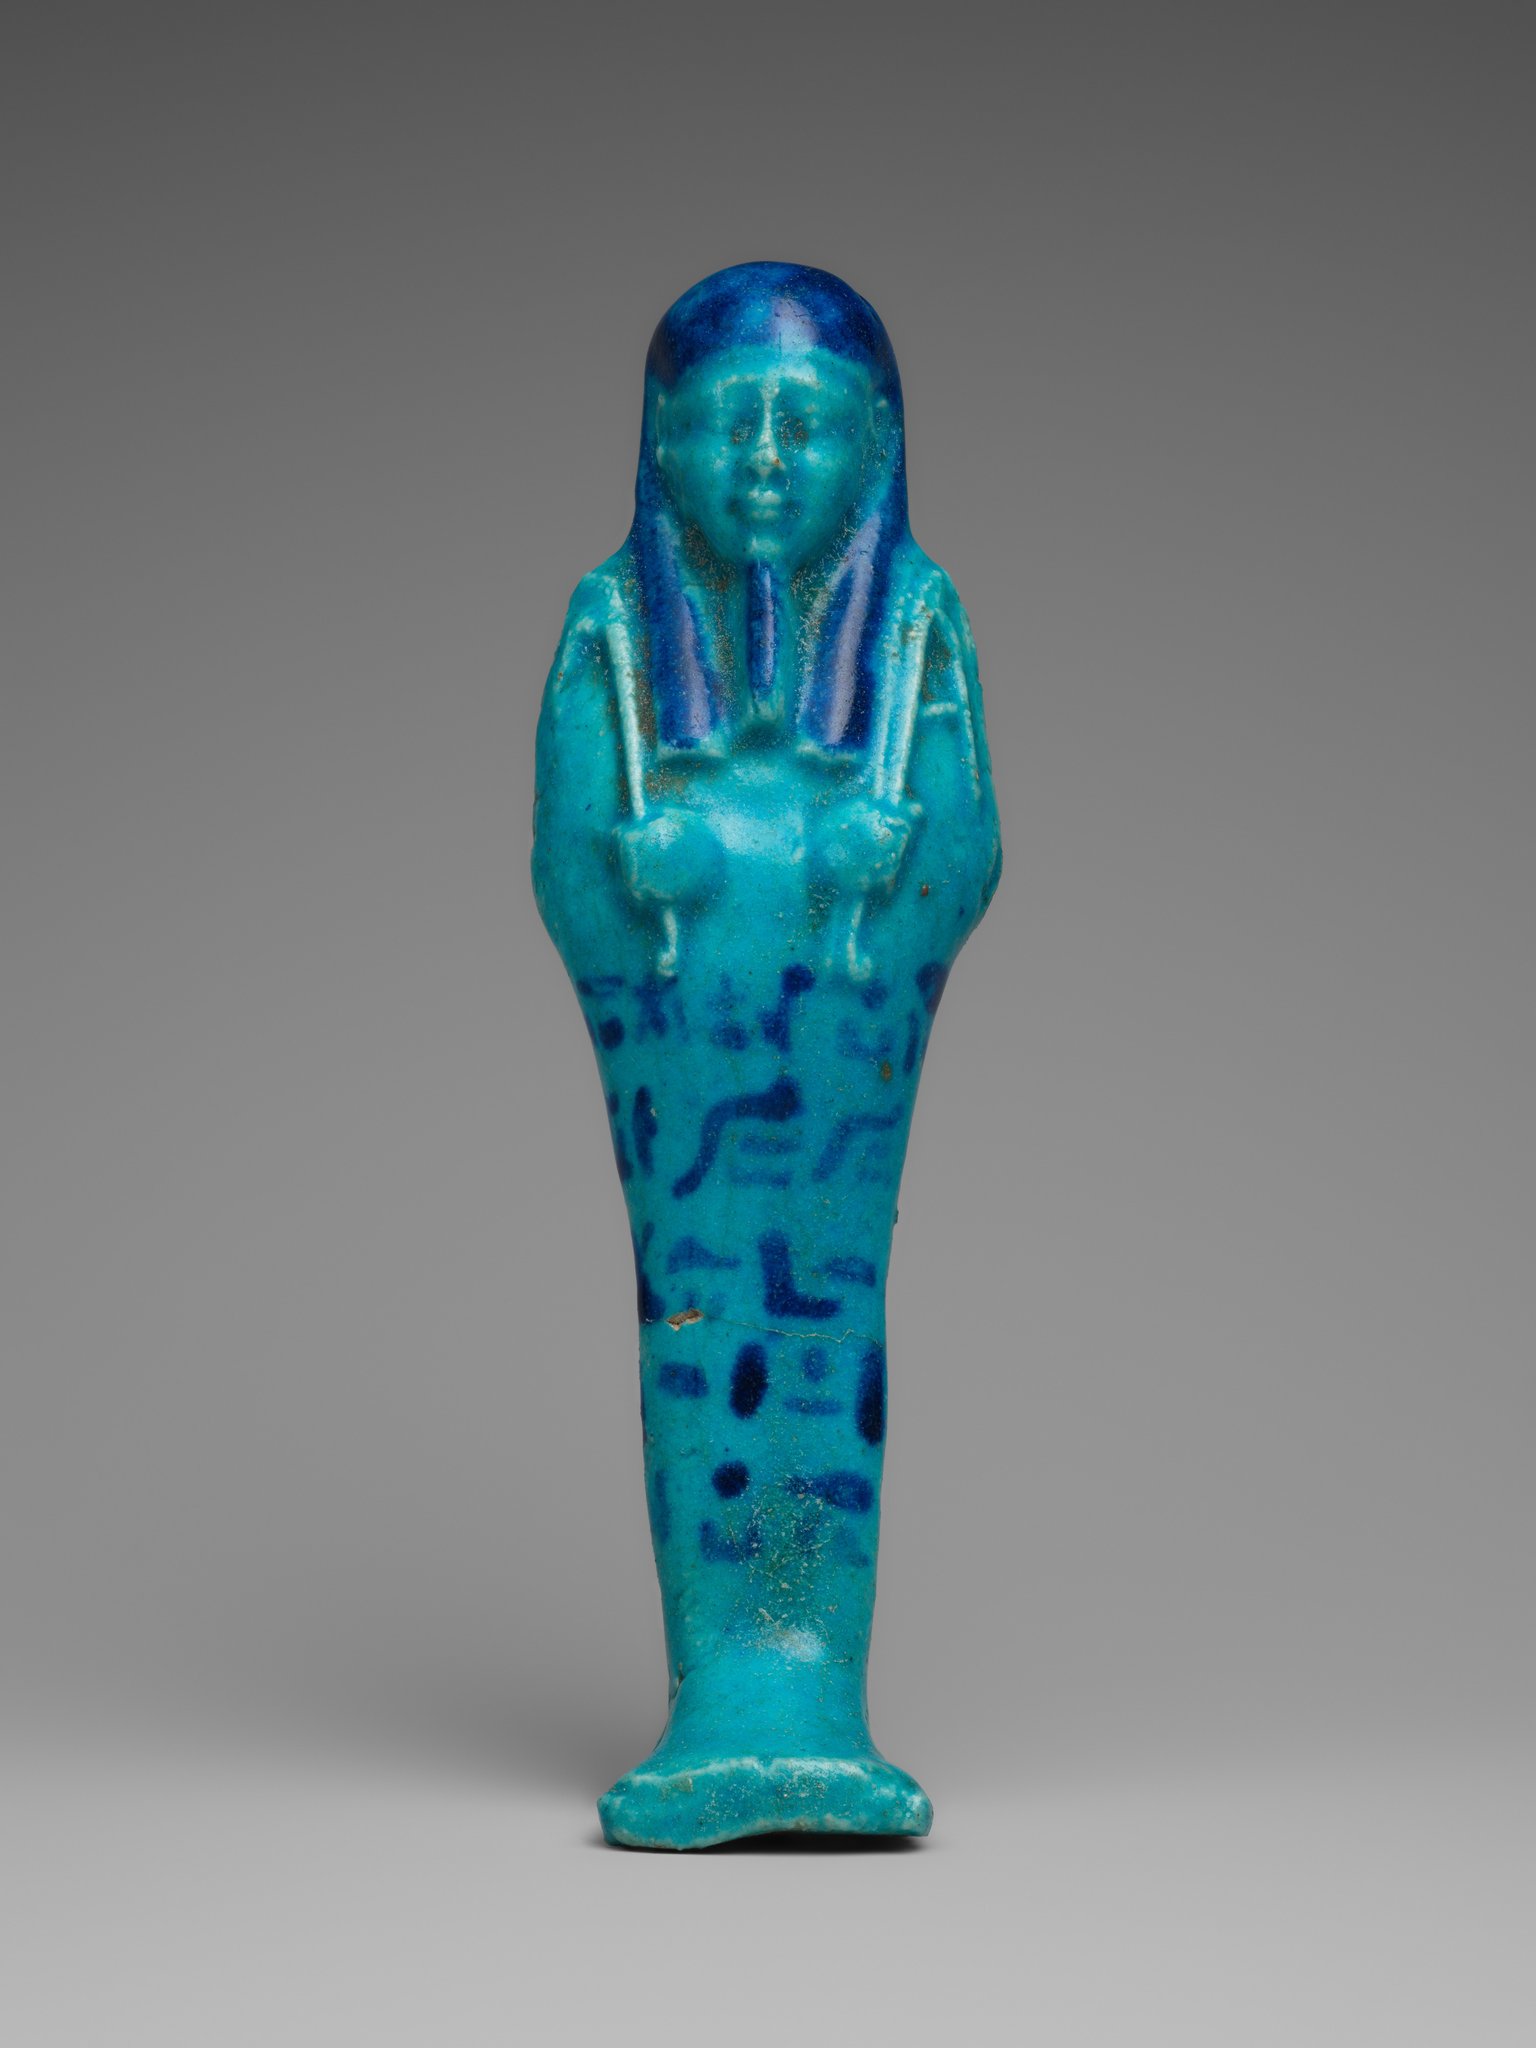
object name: shabti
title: Shabti of Padinisut(?)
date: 664-343 BCE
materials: faience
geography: egypt